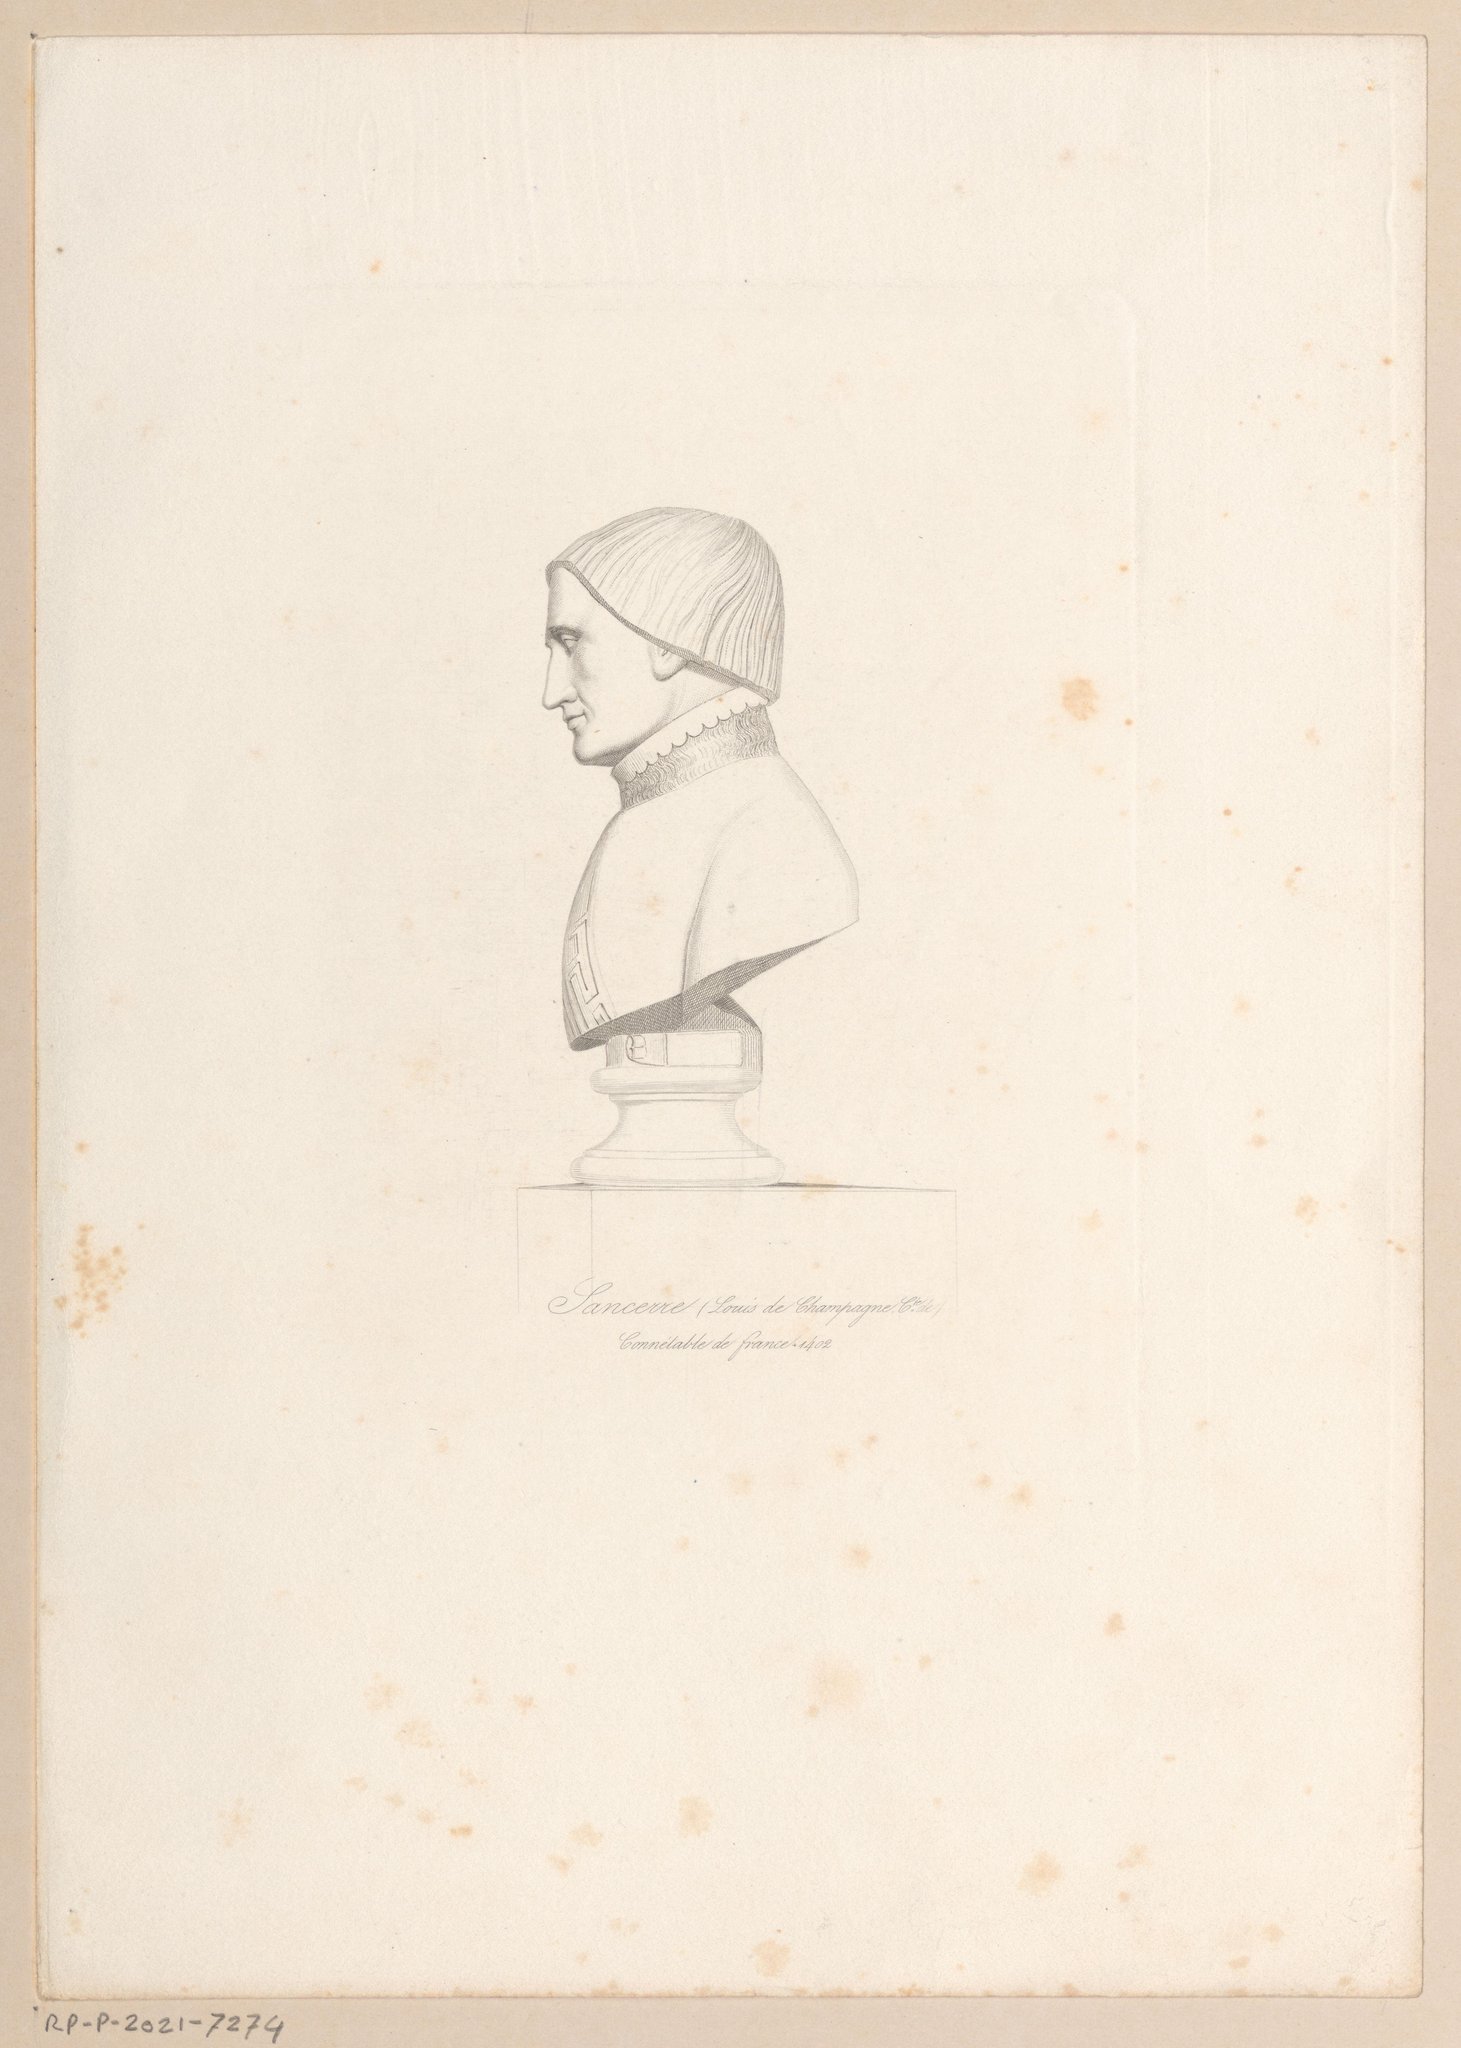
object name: print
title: Portret van Louis de Sancerre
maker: Anonymous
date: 1800-1899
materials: paper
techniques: engraving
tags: paris, commander-in-chief, general, marshal, historical persons